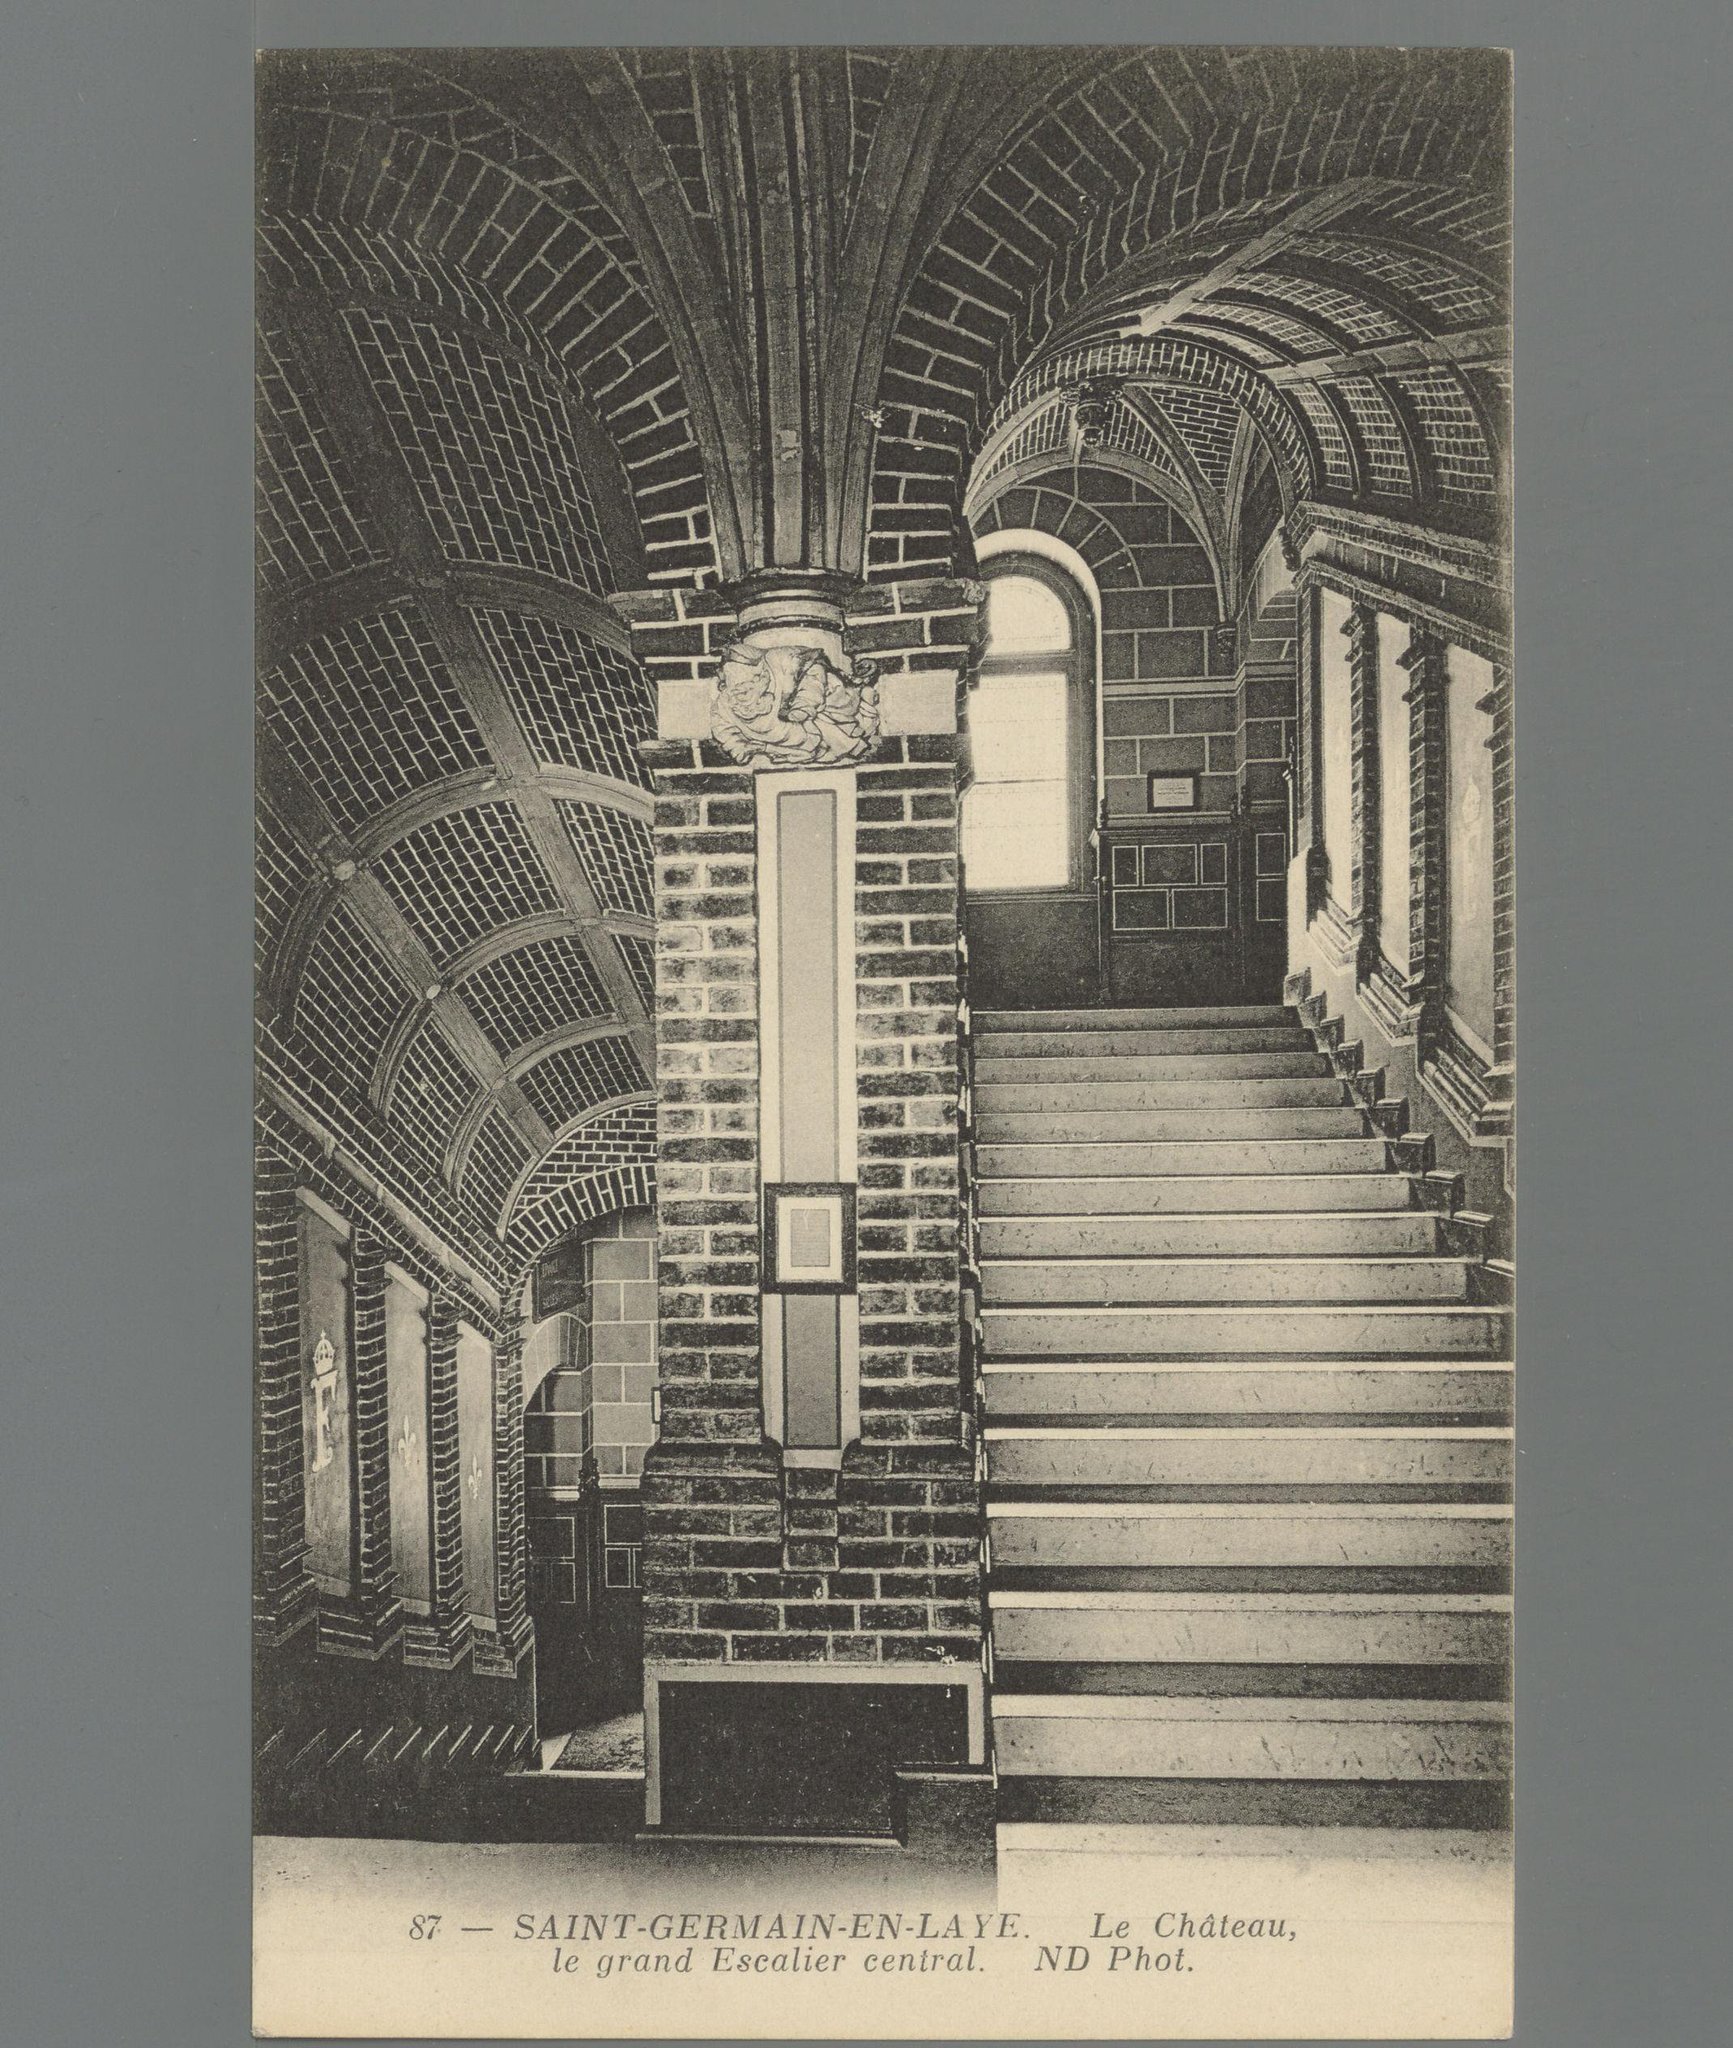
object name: photomechanical print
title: Saint-Germain-en-Laye. Le Château, le grand Escalier central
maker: Anonymous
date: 1903-1918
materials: cardboard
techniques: photograph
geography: saint-germain-en-laye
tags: castle, staircase, interior ~ representation of a building